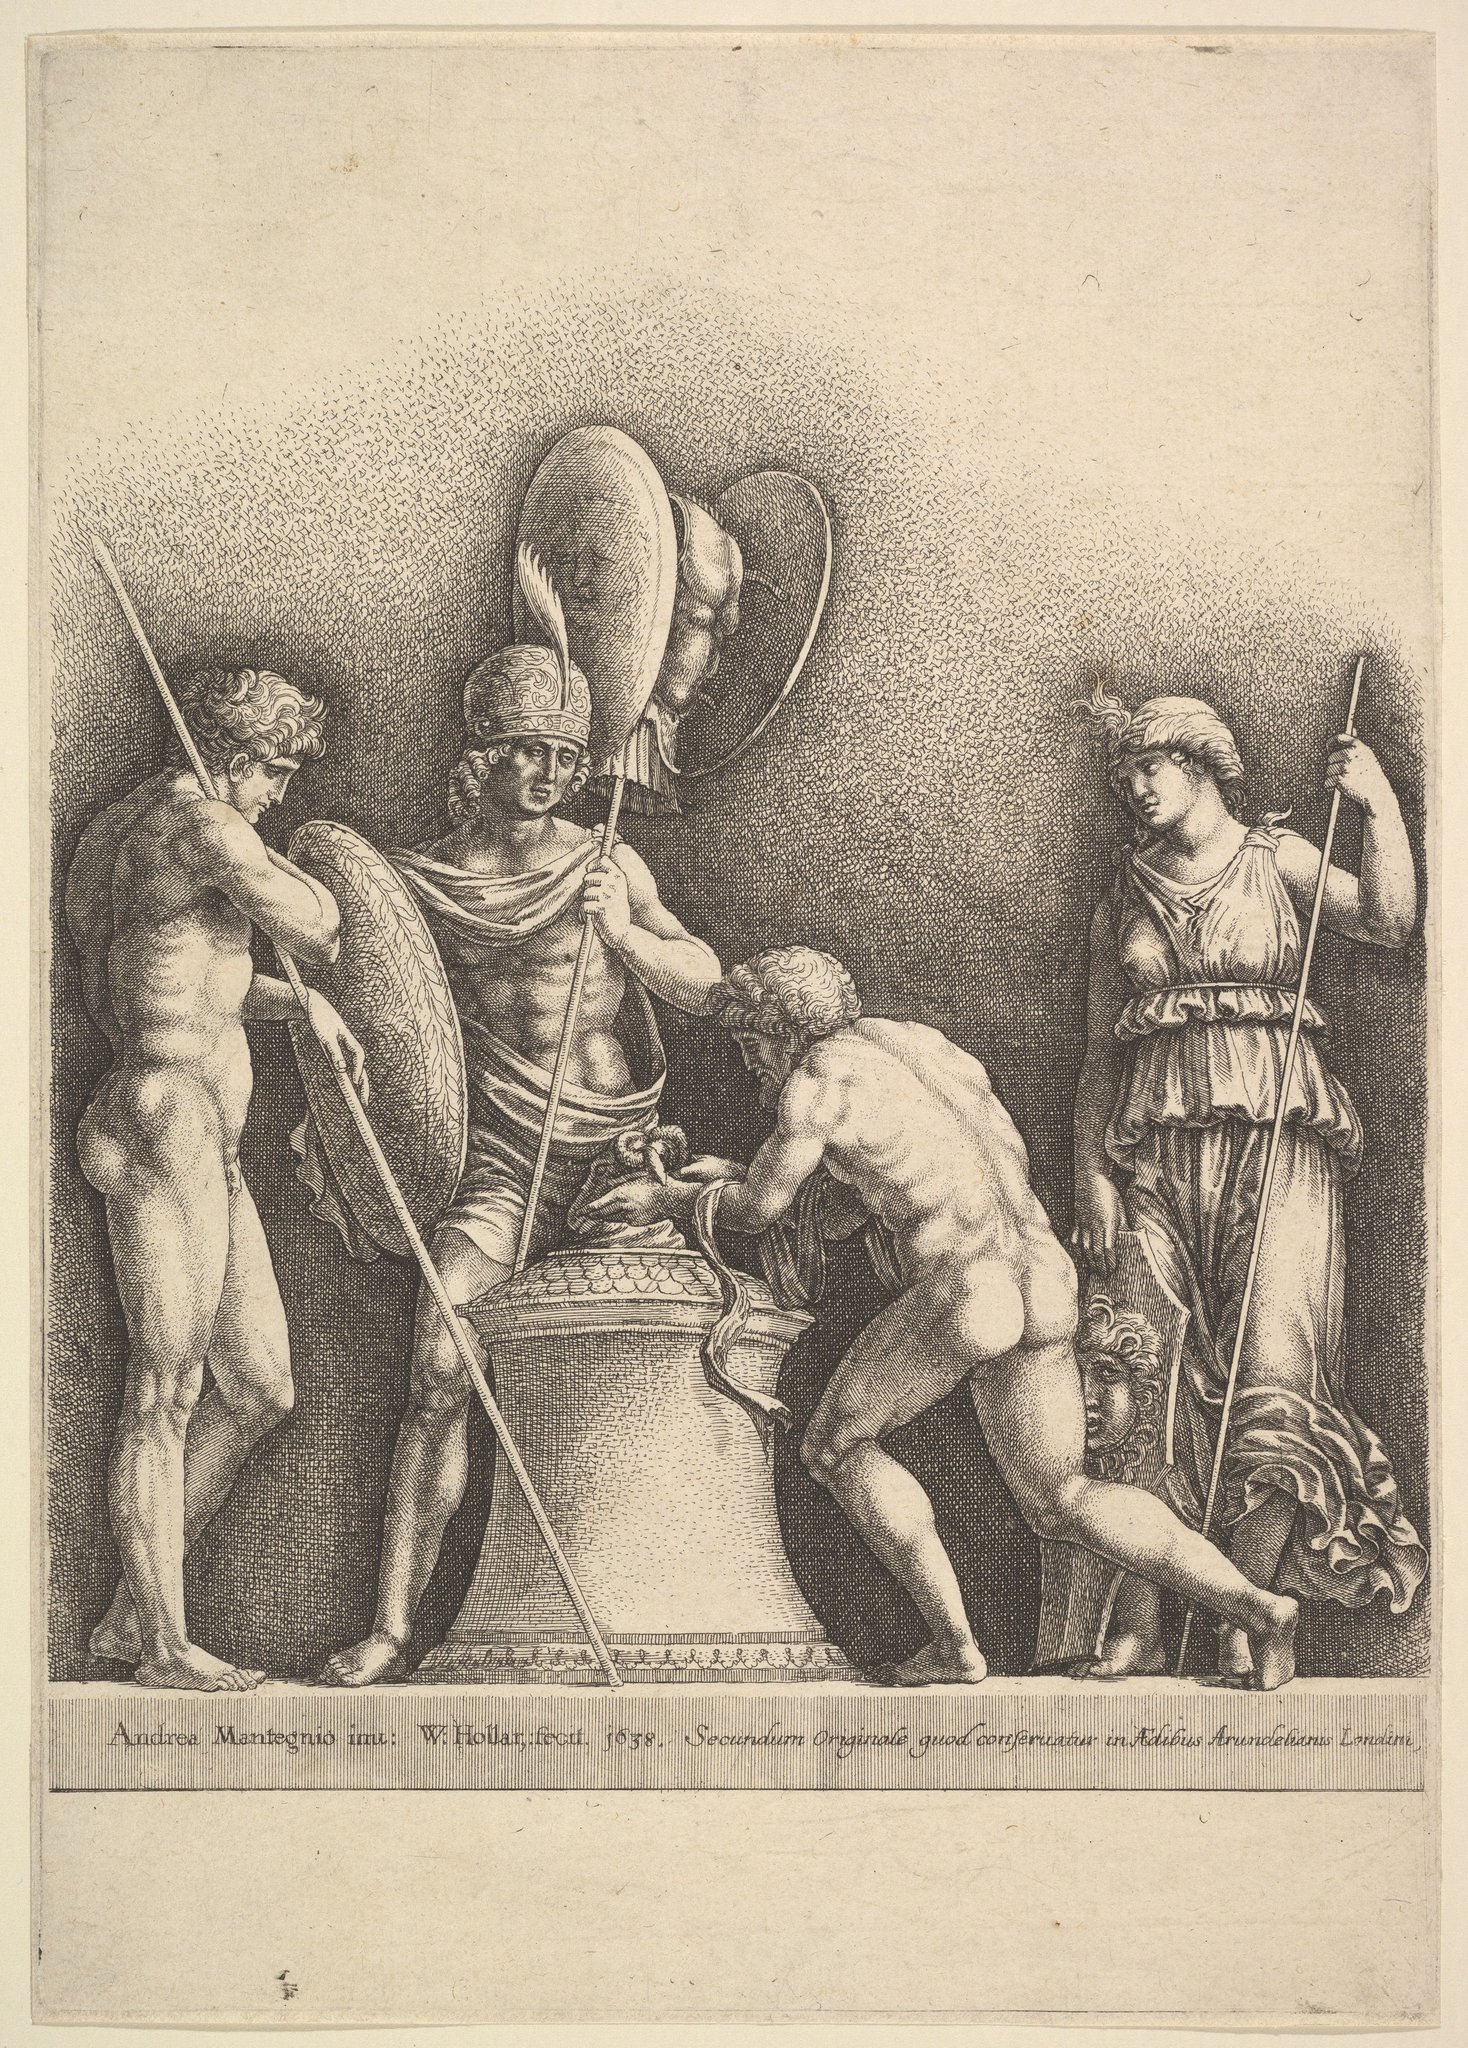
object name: print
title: Four Classical Figures (pagan sacrifice)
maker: wenceslaus hollar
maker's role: artist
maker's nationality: bohemian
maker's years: 1607-1677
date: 1638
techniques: etching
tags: prisoners,spears,men,male nudes,women